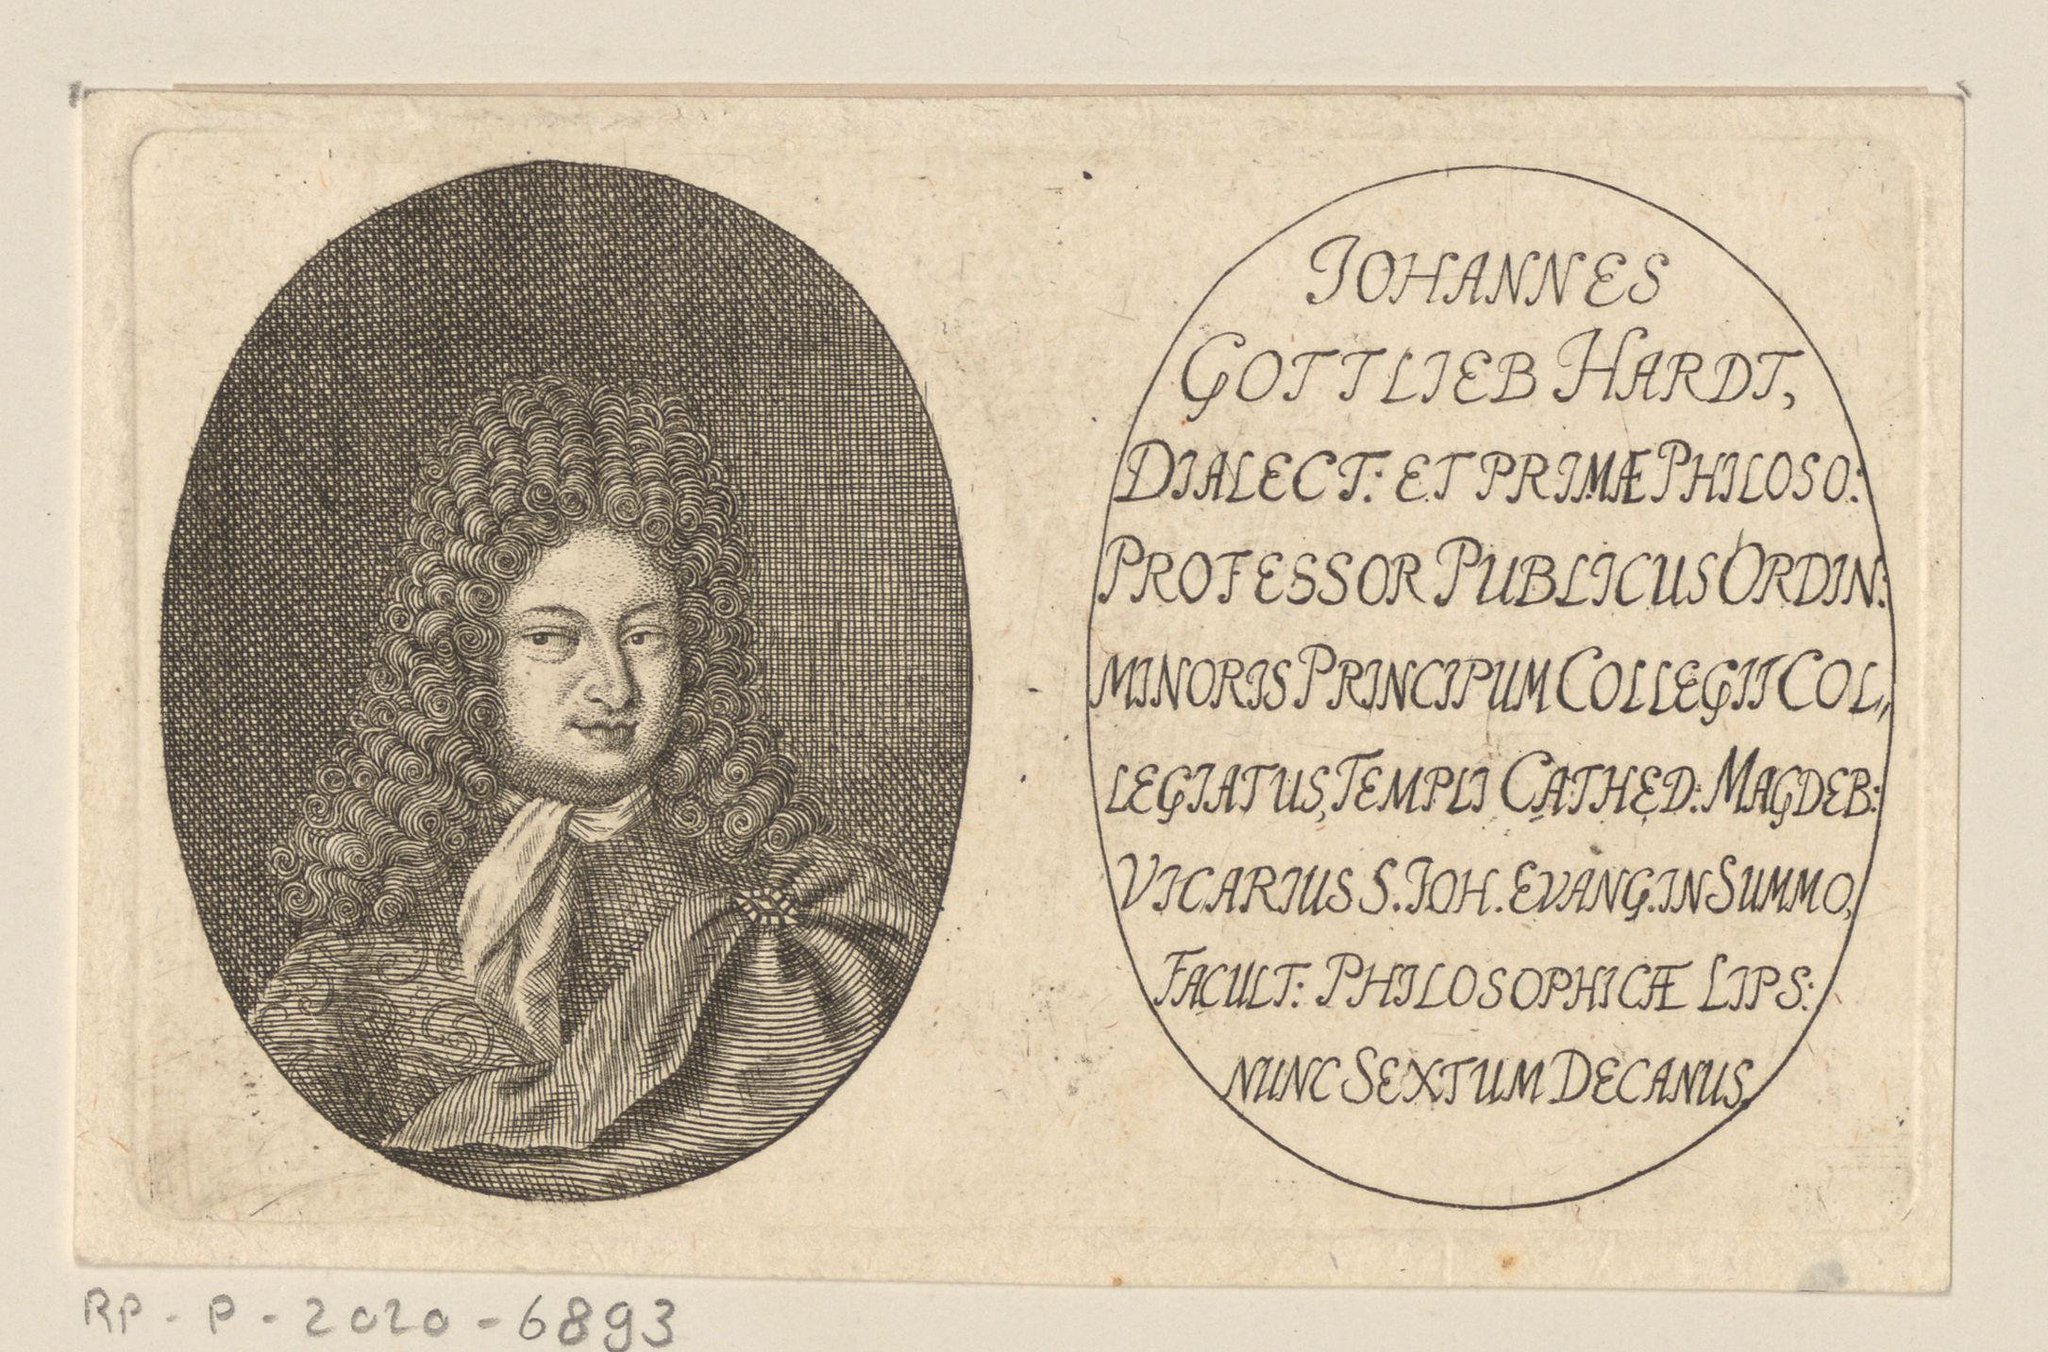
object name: print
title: Portret van Johann Gottlieb Hardt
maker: Anonymous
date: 1690-1724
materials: paper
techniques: engraving, etching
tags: scholar, philosopher, historical persons